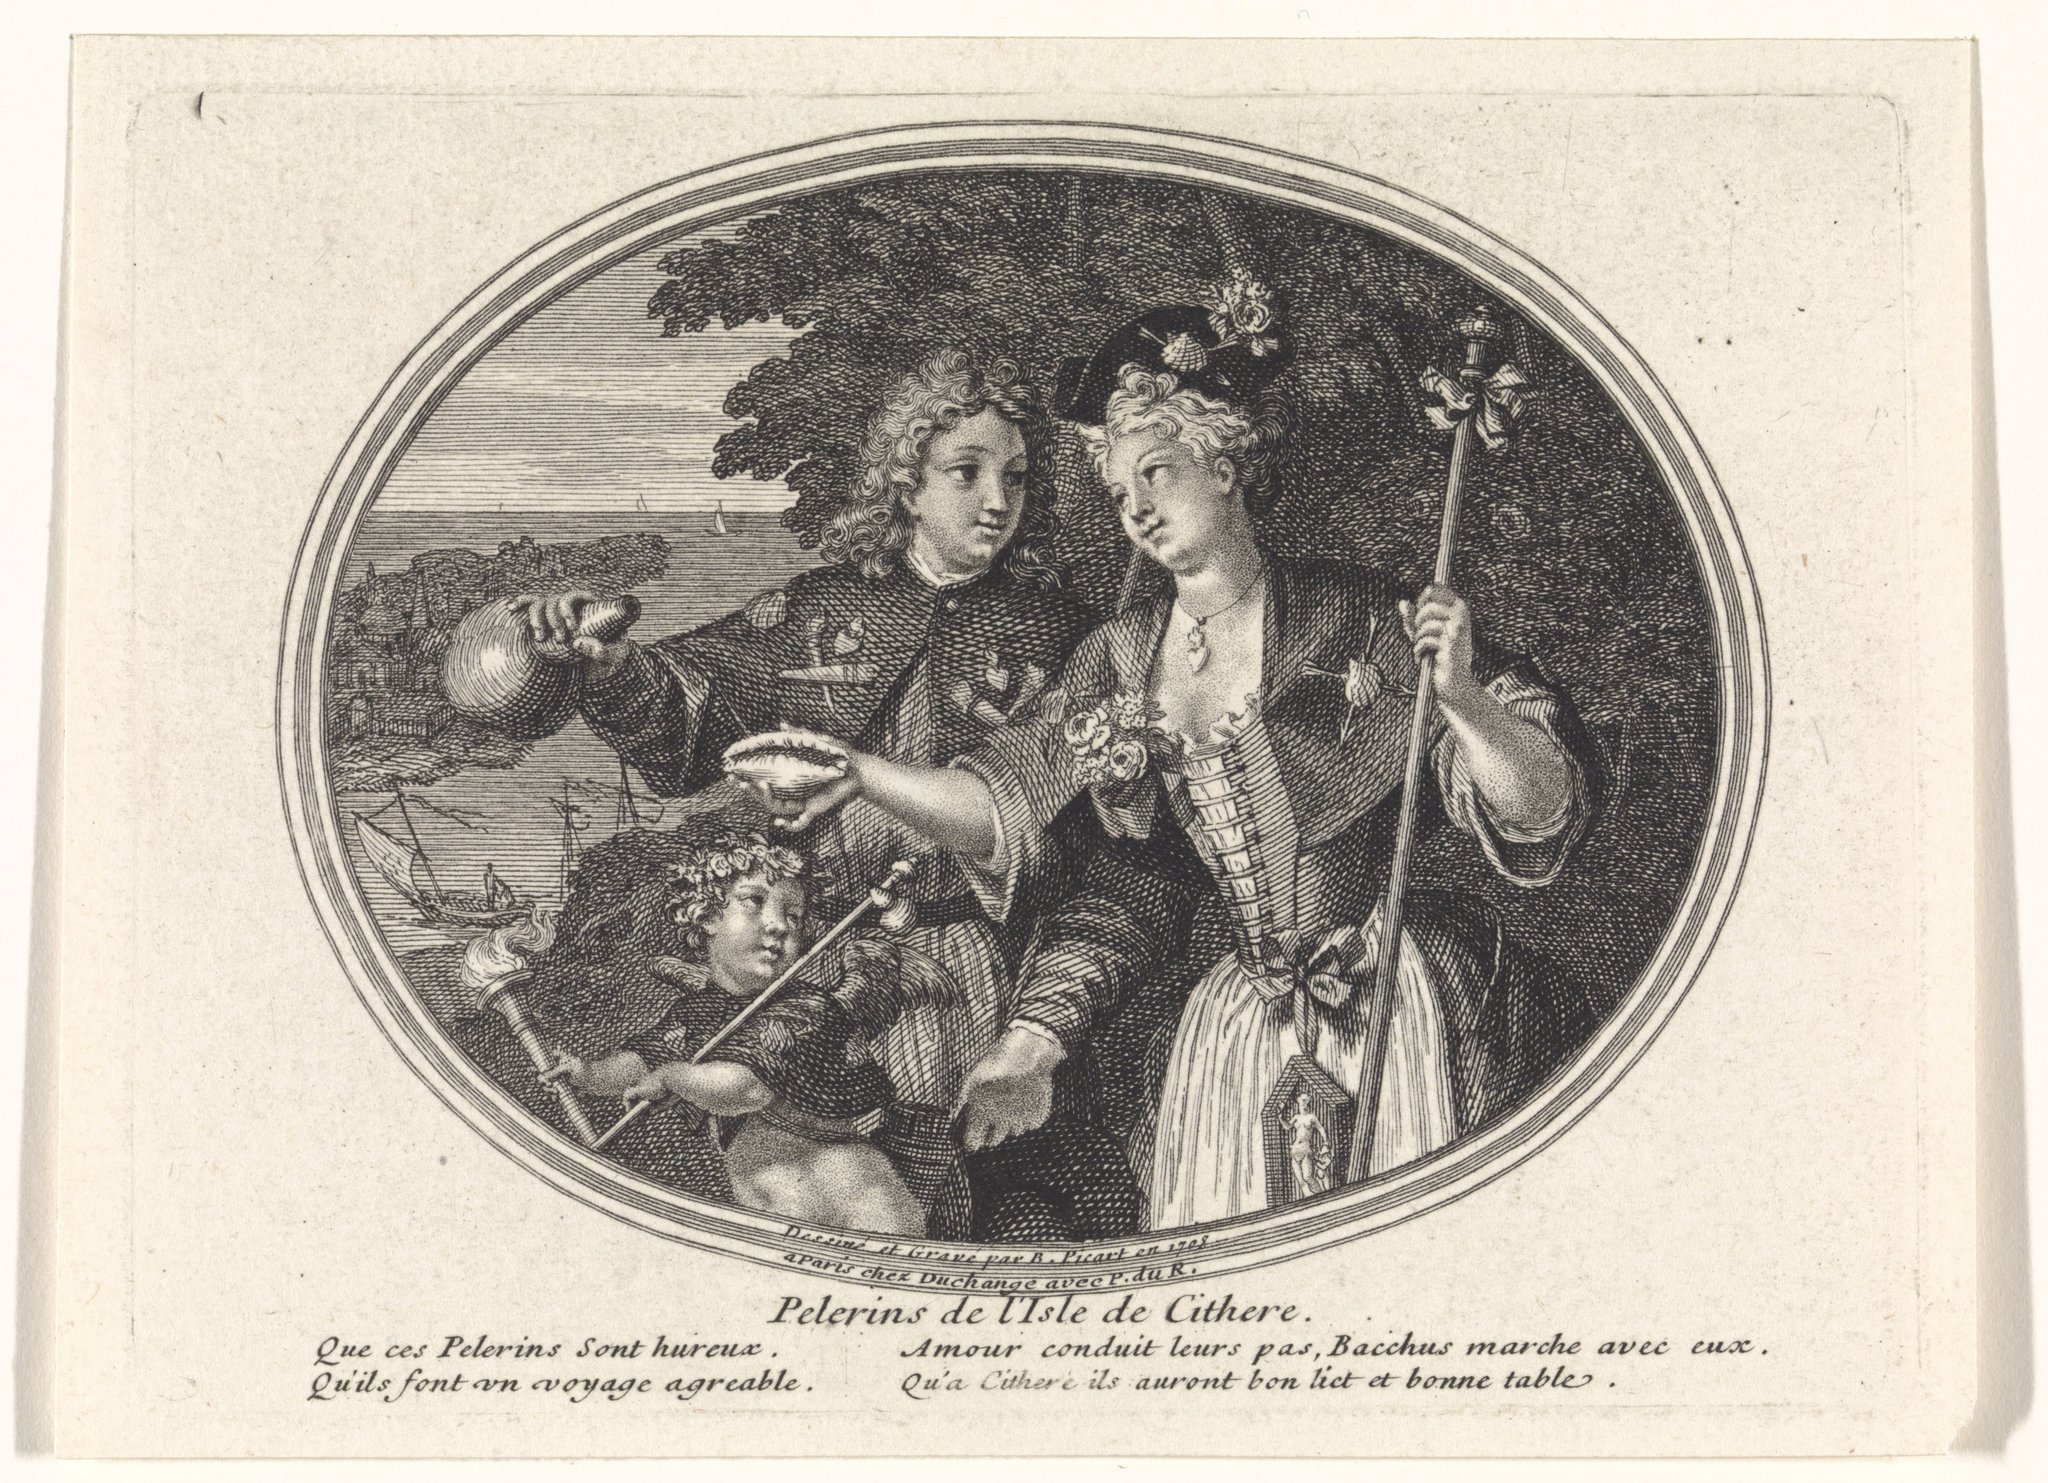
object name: print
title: Reizigers naar het eiland Cythere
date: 1708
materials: paper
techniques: engraving, etching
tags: 'ile de cythère', 'en route', traveller under way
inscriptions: caption: ‘vierregelig vers’, title: ‘Pelerins de l'Isle de Cithere’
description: Binnen een ovaal zijn een rijk geklede dame en heer voor bossage afgebeeld. De dame (Venus) omvat met haar linkerhand een staf, hier als attribuut van de pelgrim bedoeld. De schelp in haar rechterhand heft zij op als een glas. De man schenkt er vanuit een kruik wijn in. Voor het liefdespaar staat de halfnaakte Bacchus, god van de wijn, met een kroon van wingerdbladeren en in zijn hand een thyrsus, een staf met een knop in de vorm van een dennenappel (een oud vruchtbaarheidssymbool). Tevens houdt hij een toorts met brandend vuur vast. Ook op de voorgrond een kleine, gebeeldhouwde voorstelling van een herme. Een dergelijke herme werd gebruikt bij het ‘geheime huwelijksritueel’, verbonden met reiniging en vruchtbaarheid. Op de achtergrond zijn bootjes en het eiland Cythere, voor de kust van Laconia in Zuid-Griekenland, te zien. De prent verwijst naar het thema ‘Inscheping naar Cythera’: jongens en meisjes afkomstig uit alle standen en gekleed als pelgrims maken zich op om aan boord te gaan van een boot die hen naar de Tempel van de Liefde op het eiland zal brengen.